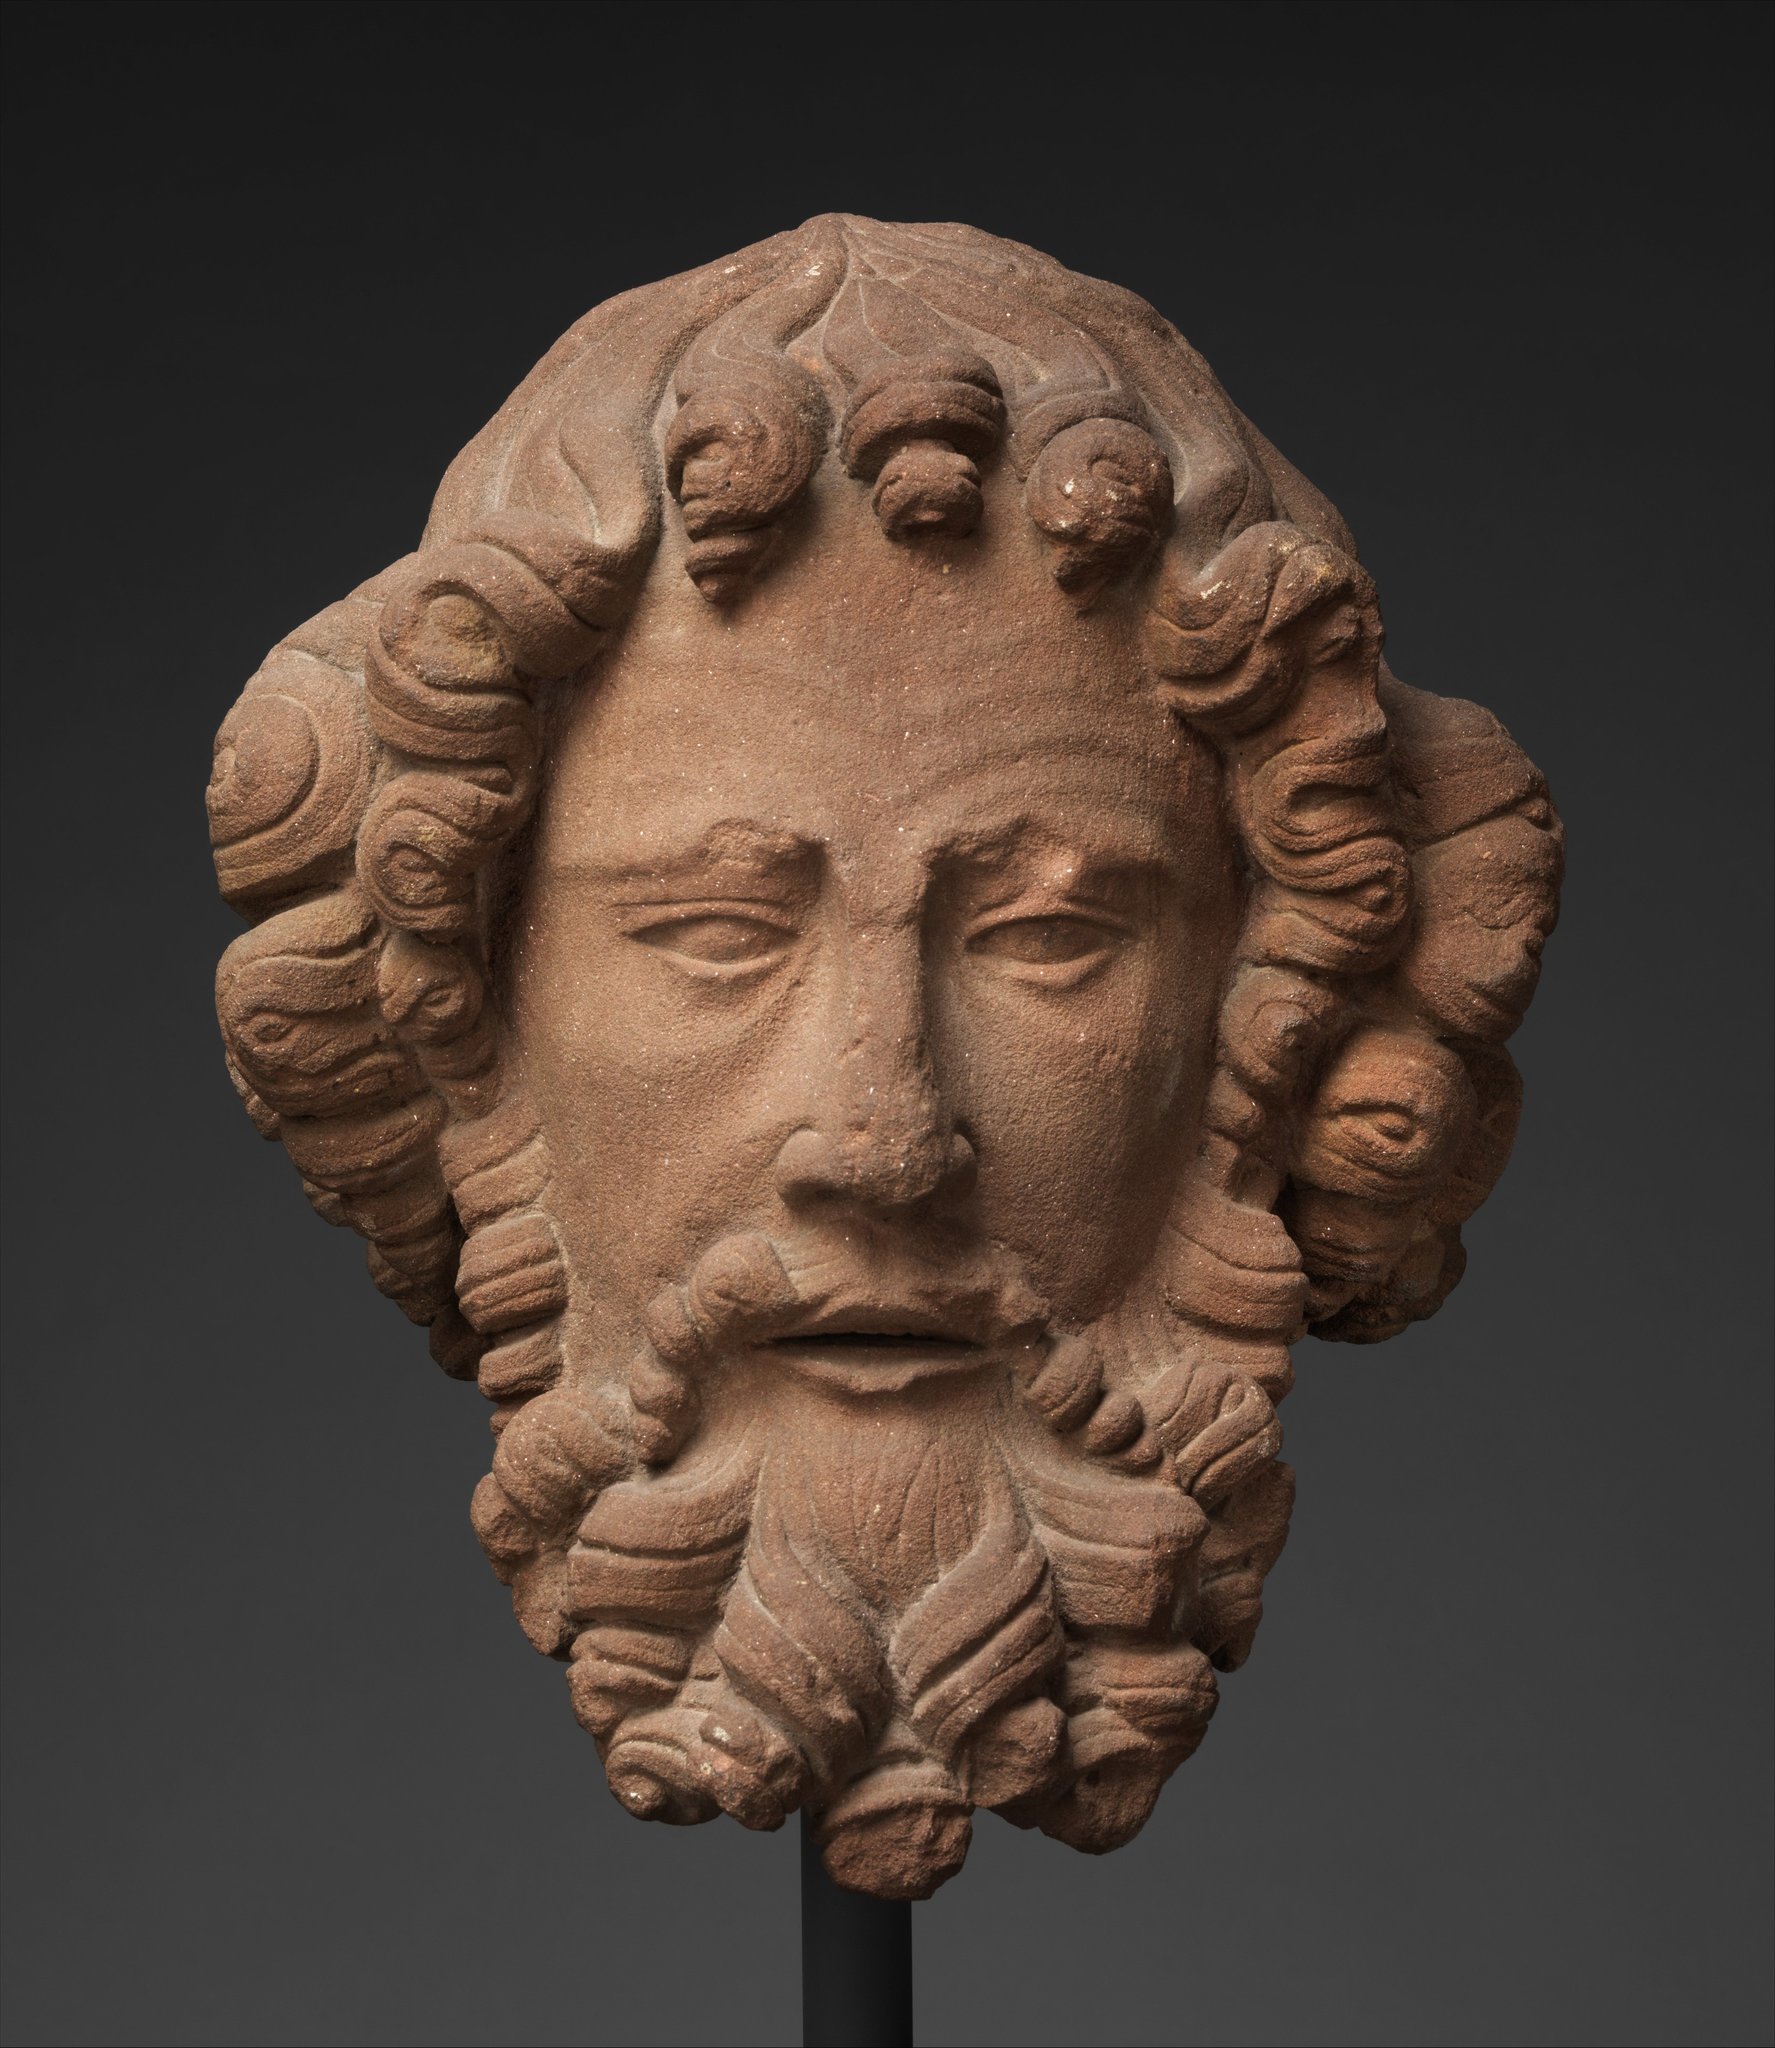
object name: statue head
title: Head of an Apostle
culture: german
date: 1280-1300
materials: stone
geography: france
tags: heads,men,apostles